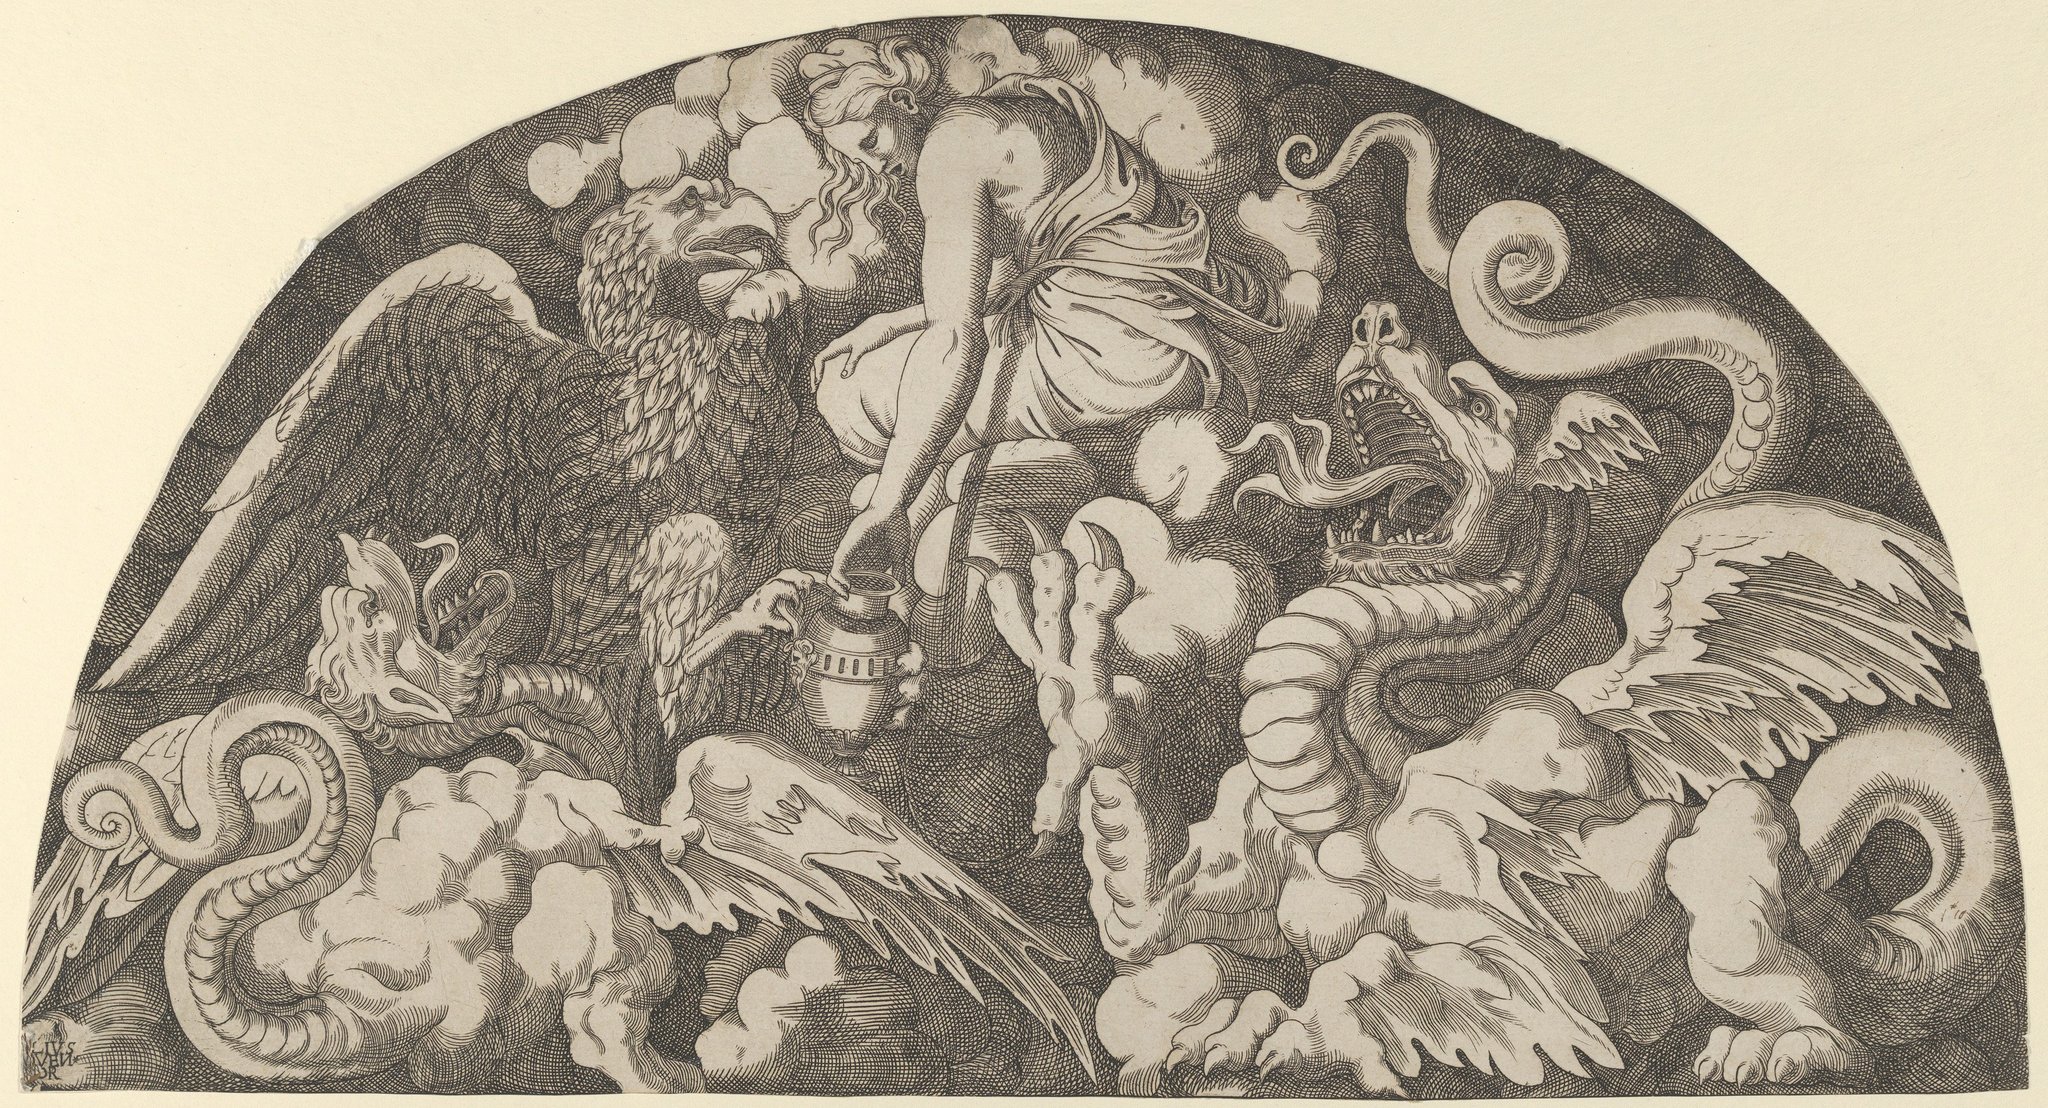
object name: print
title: Jupiter's Eagle Bringing Water of the Styx to Psyche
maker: léon davent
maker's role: artist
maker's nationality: french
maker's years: 1540-1556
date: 1540-1556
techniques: engraving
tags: eagles,psyche,dragons